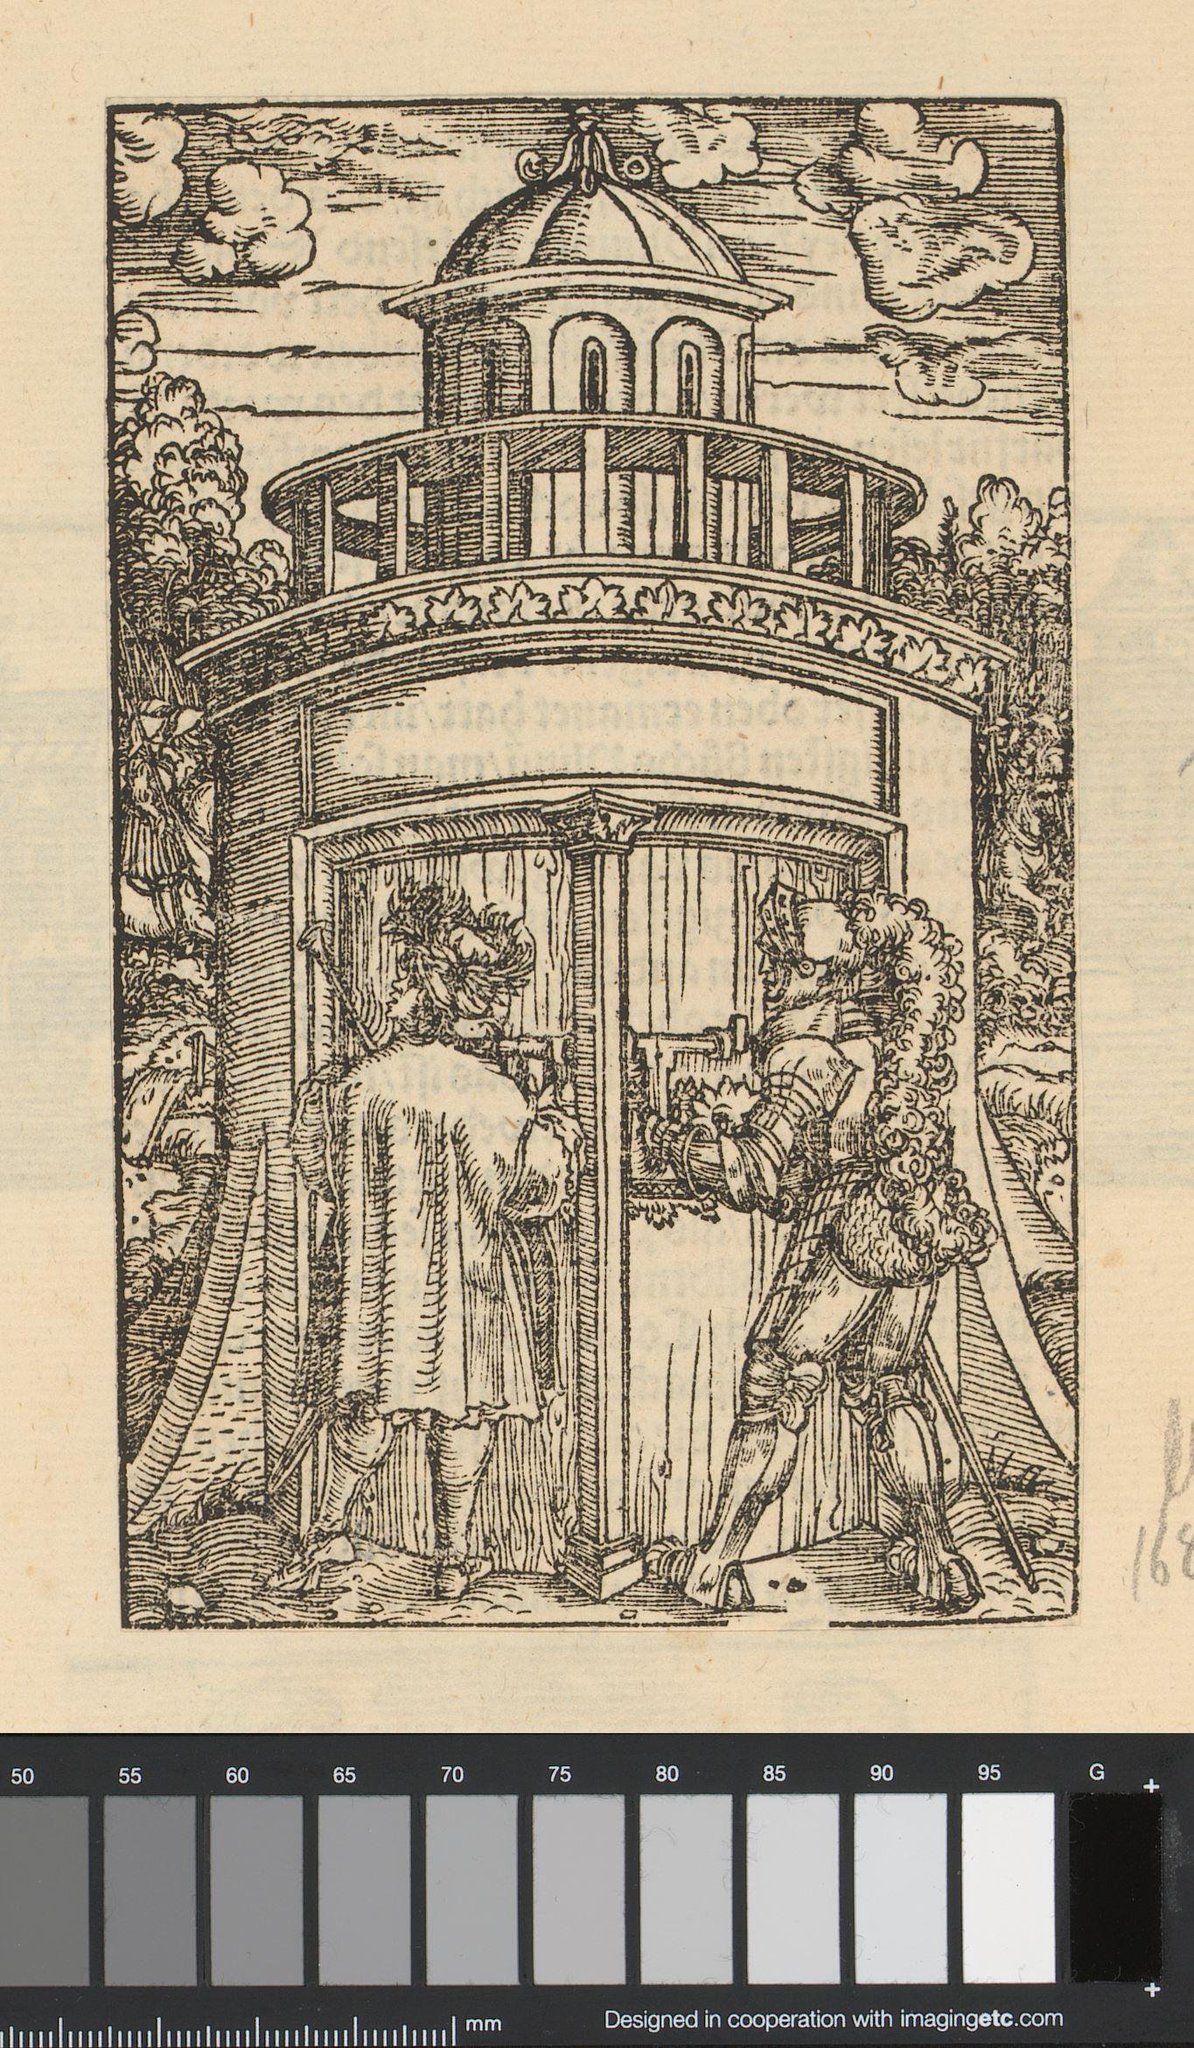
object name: print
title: Twee heersers bij een ronde tempel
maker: Anonymous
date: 1514-1532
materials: paper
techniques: letterpress printing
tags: peace negotiations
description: Deze prent is gebruikt in: Petrarca, Francesco. Von der Artzney bayder Glück, des guten und widerwertigen: unnd weß sich ain yeder inn Gelück und Unglück halten sol (...). Augsburg: Heinrich Steiner, 1532. Deze uitgave is ook bekend onder de titel 'Trostspiegel in Glück und Unglück'.